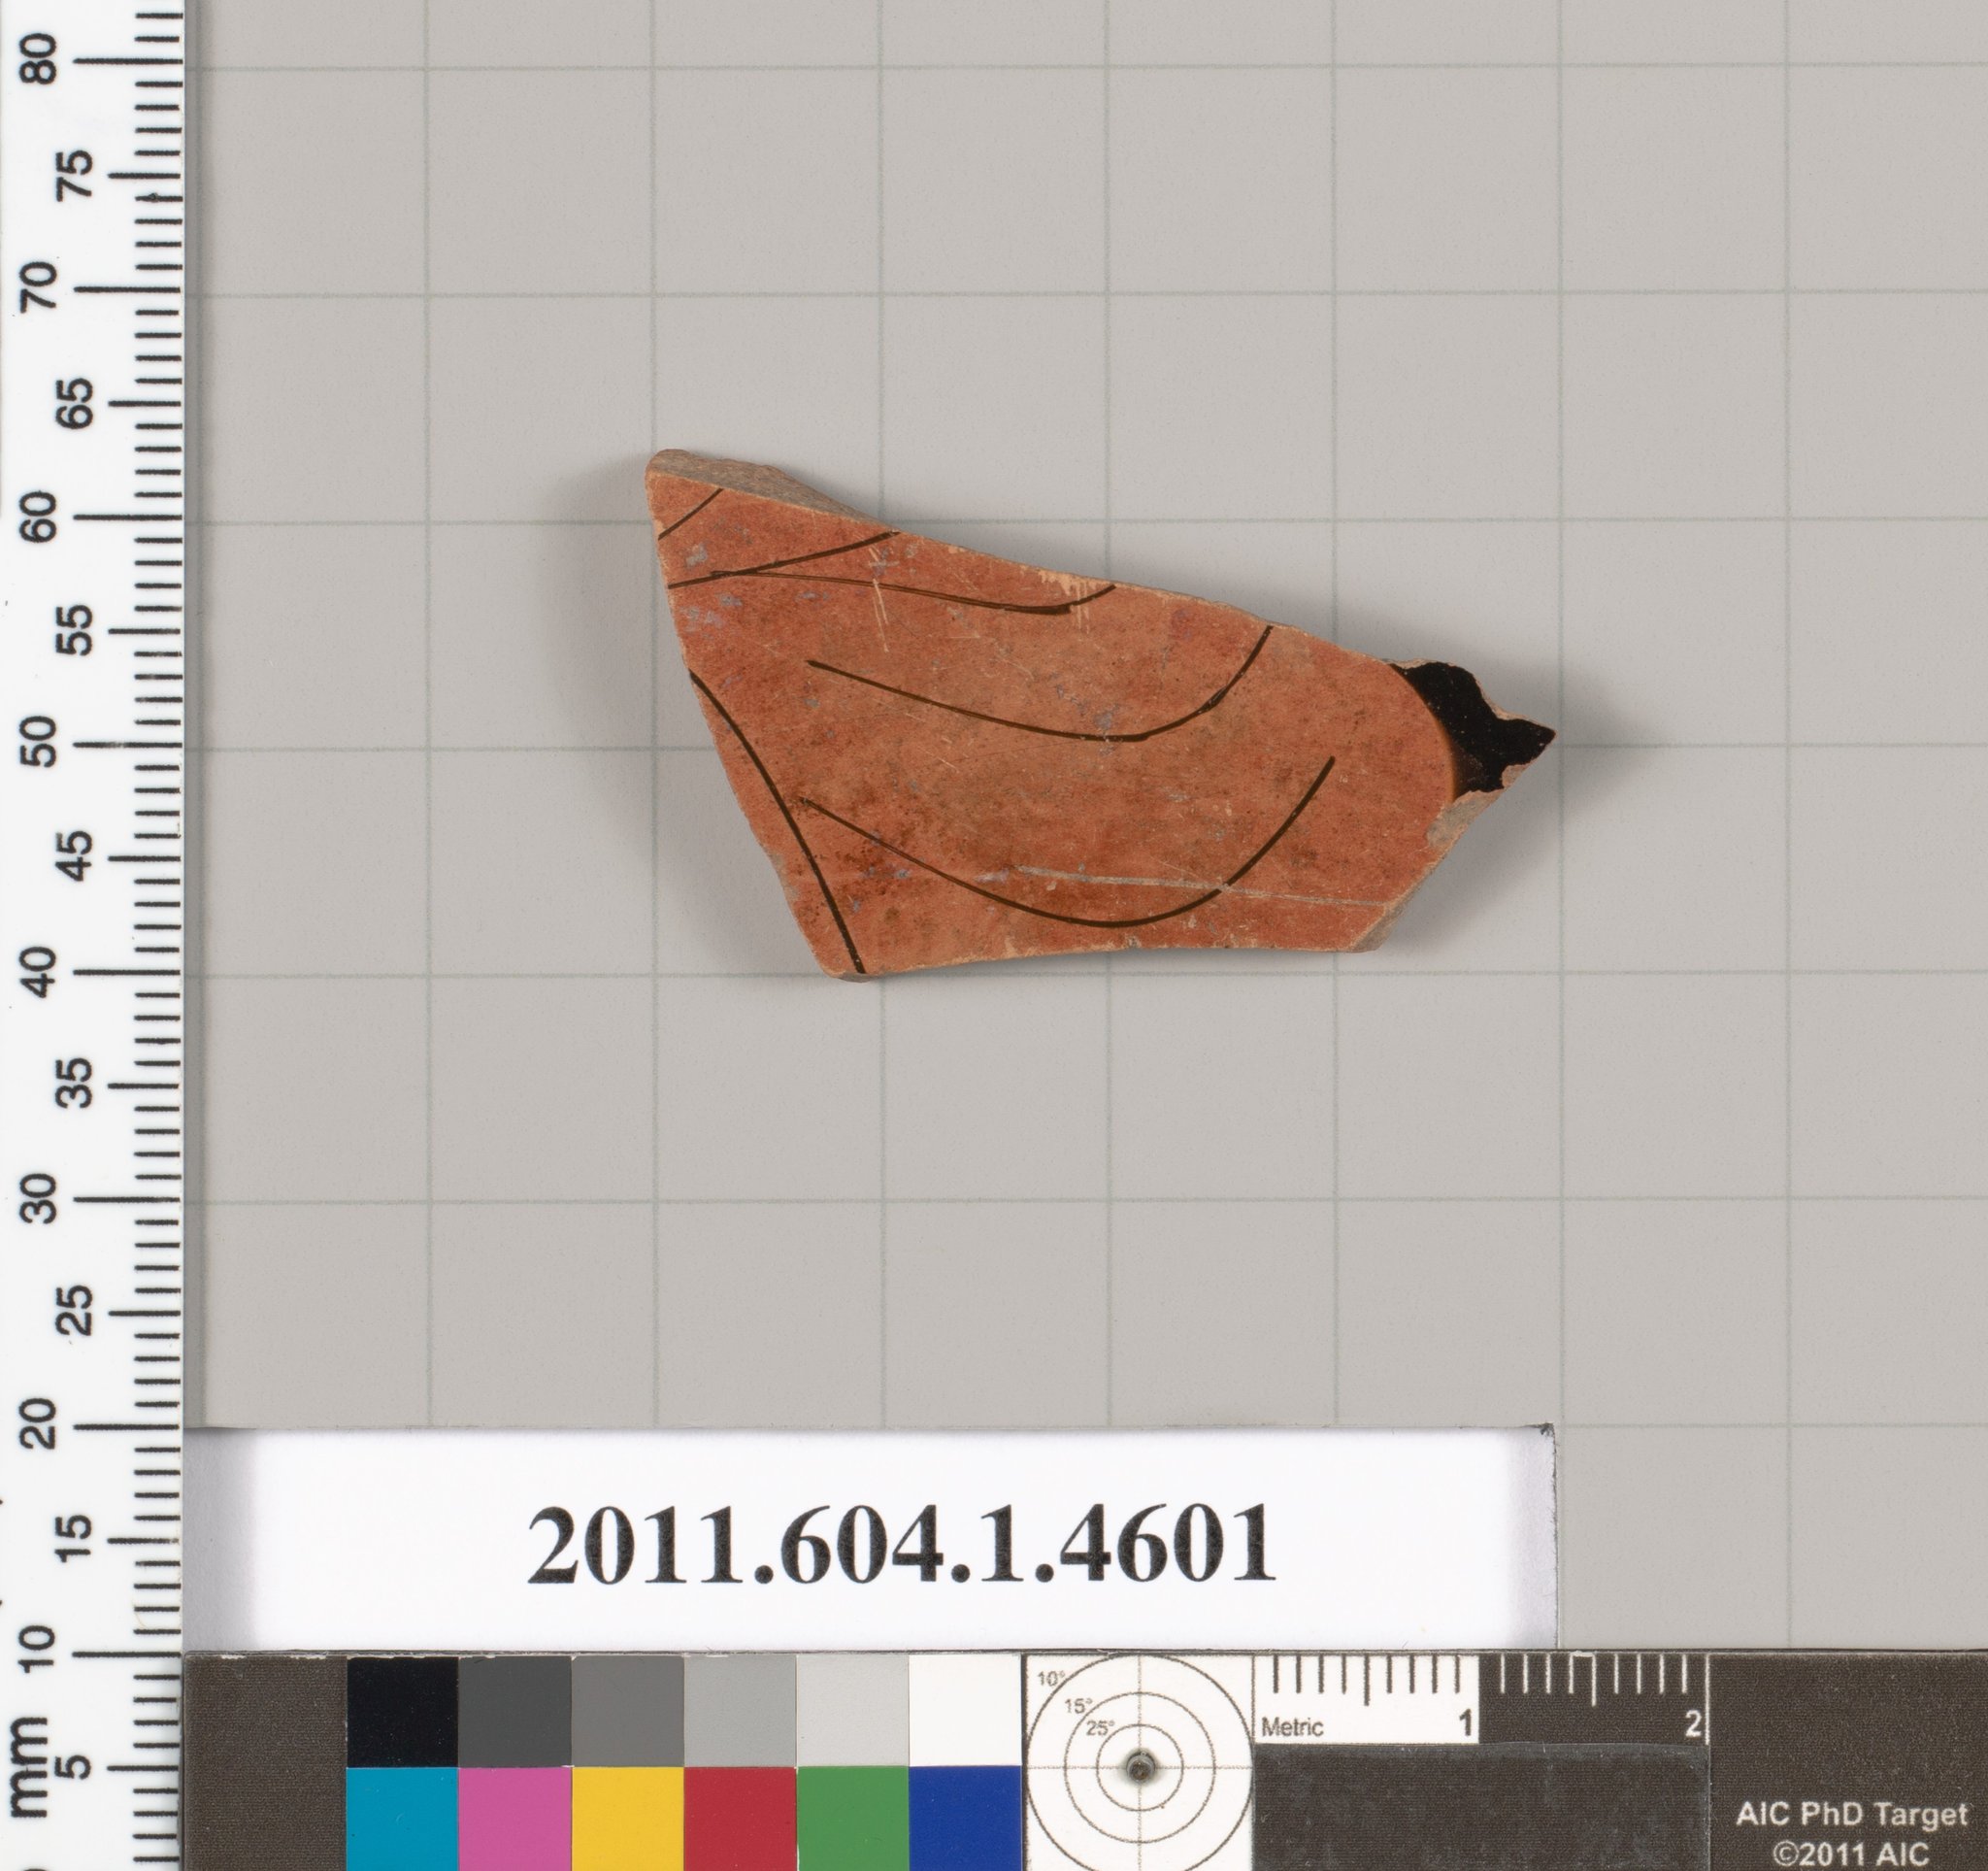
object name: kylix fragment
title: Terracotta fragment of a kylix (drinking cup)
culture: greek, attic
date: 475-451 BCE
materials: terracotta